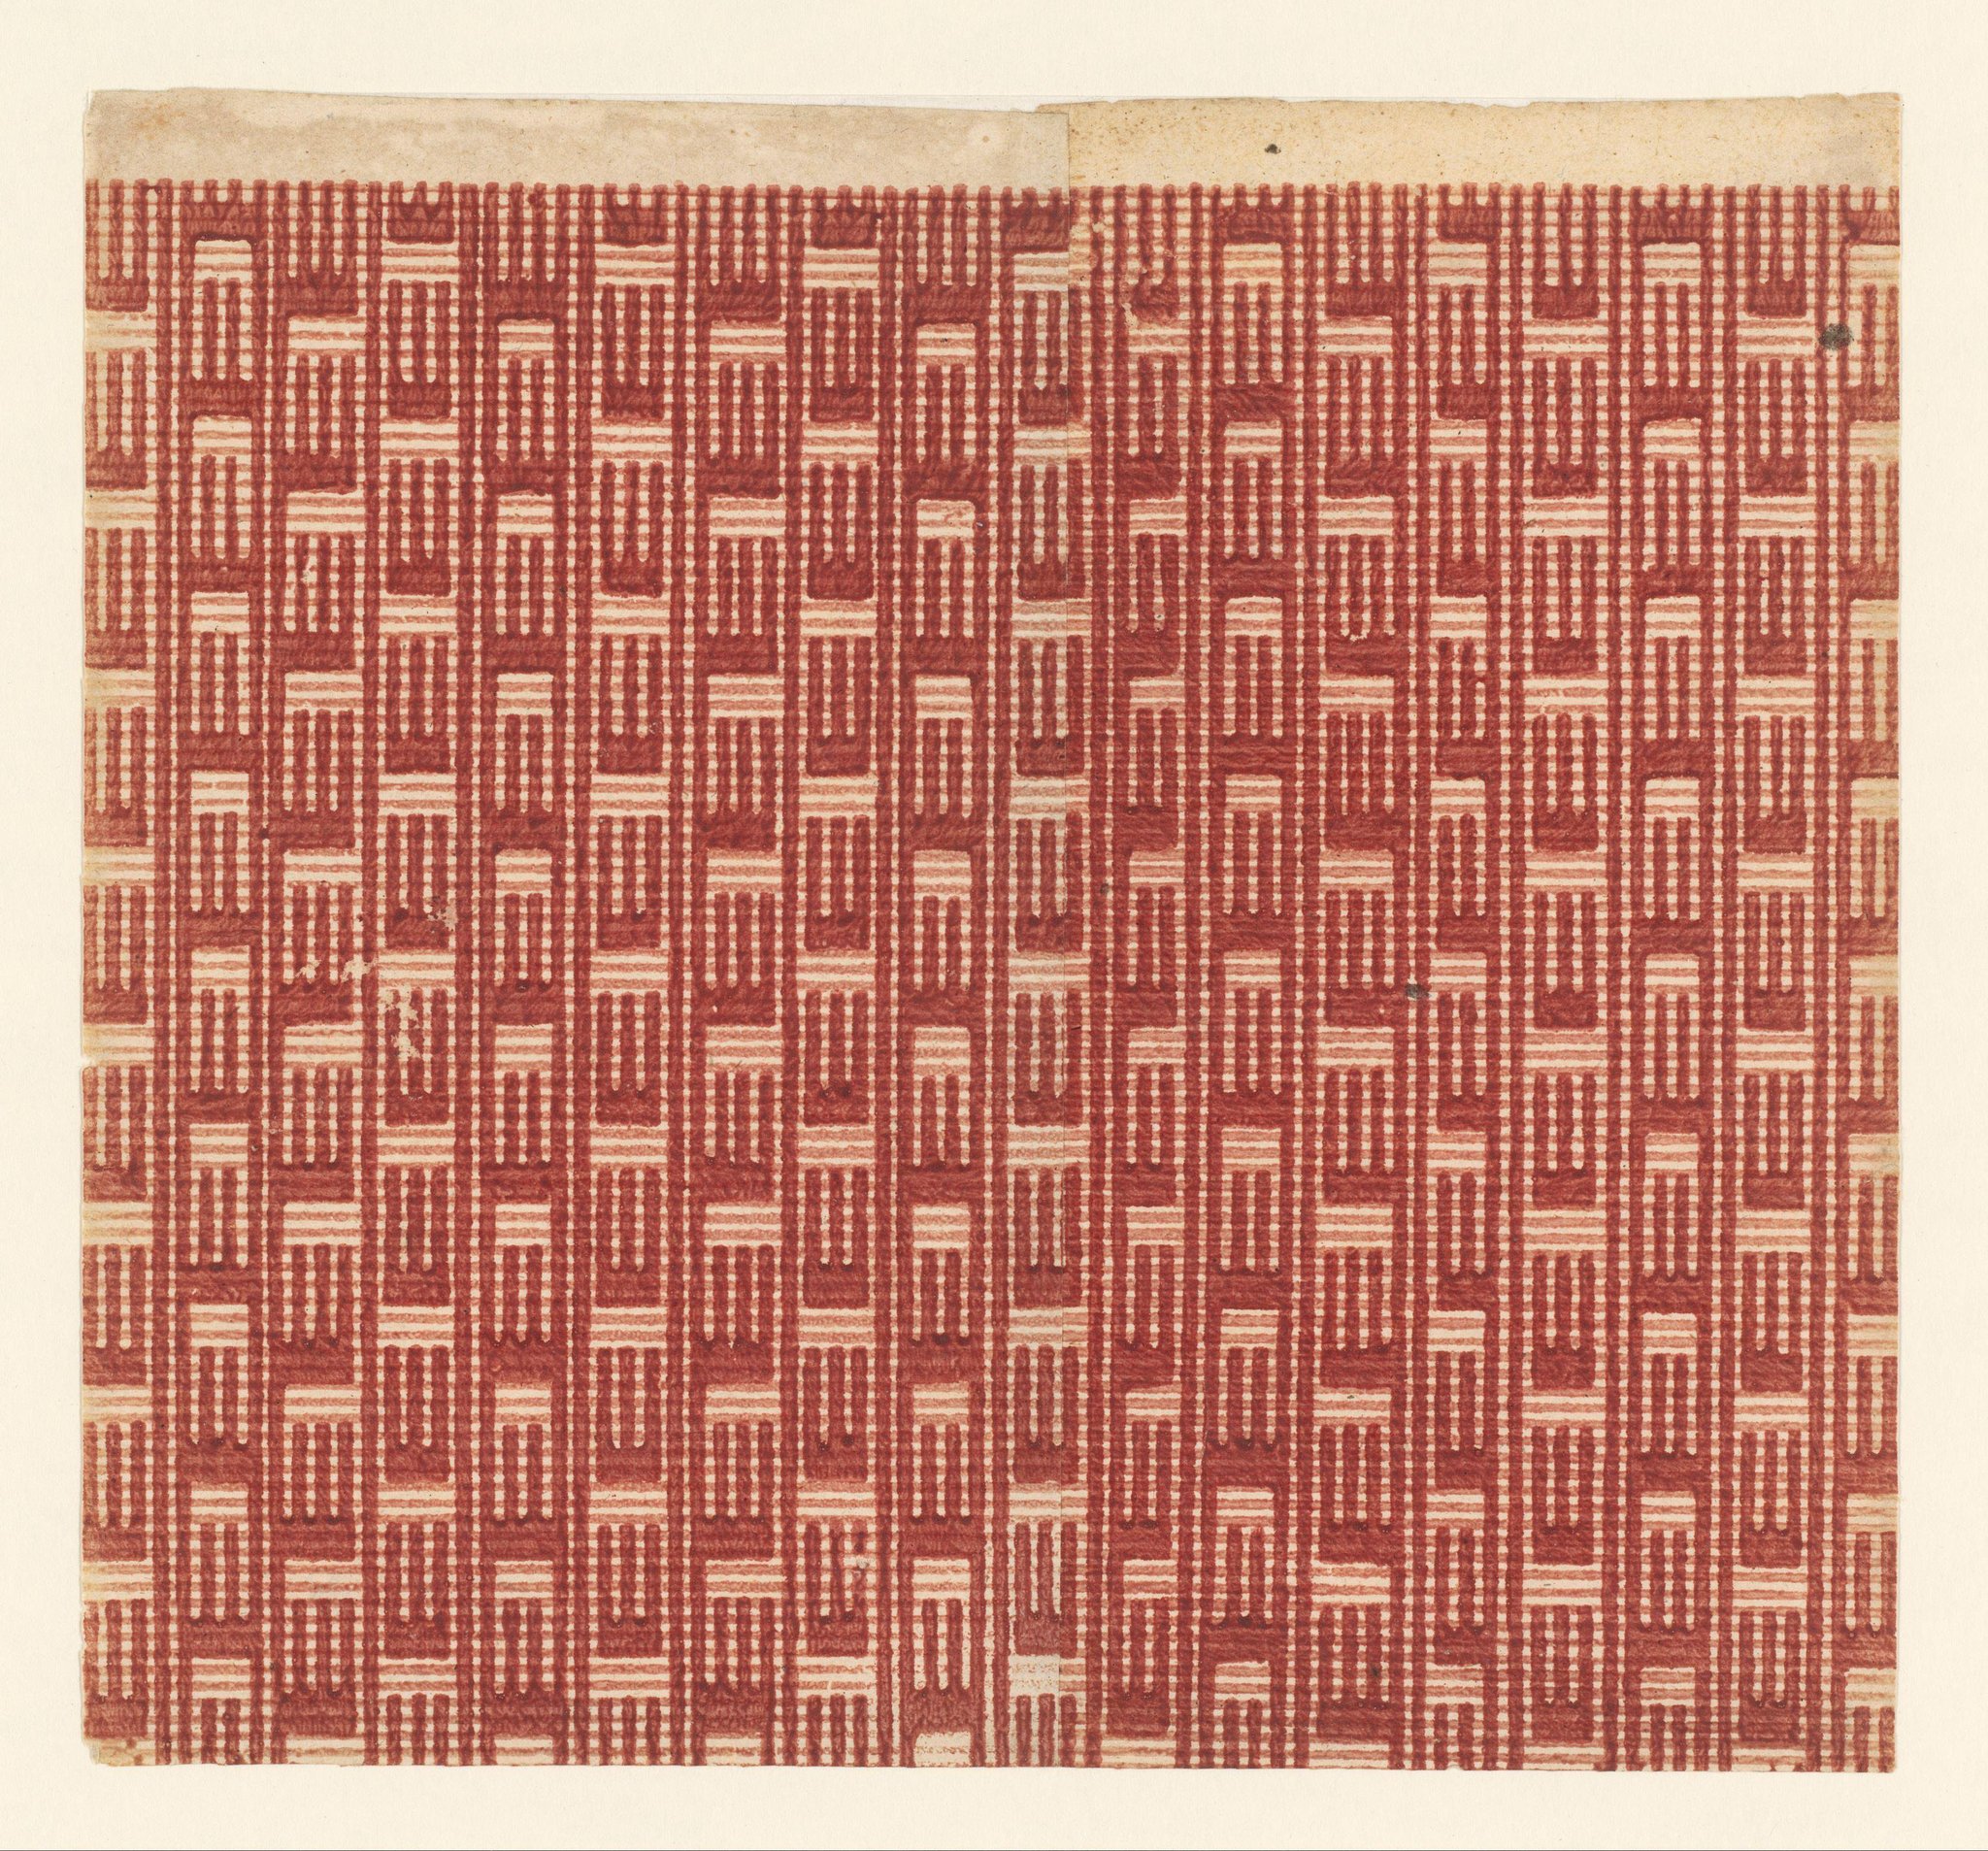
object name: wrapper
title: Blad met geometrisch banenpatroon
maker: Anonymous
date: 1766-1806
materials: paper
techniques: printing block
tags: ornament ~ geometric motifs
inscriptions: annotation: ‘Bijlaer Port vd N.R. 1786 283e’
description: Blad met verticaal geometrisch banenpatroon met E-motief over doorlopend horizontaal lijnenfond. Deel van een omslag voor een publicatie uit 1786.